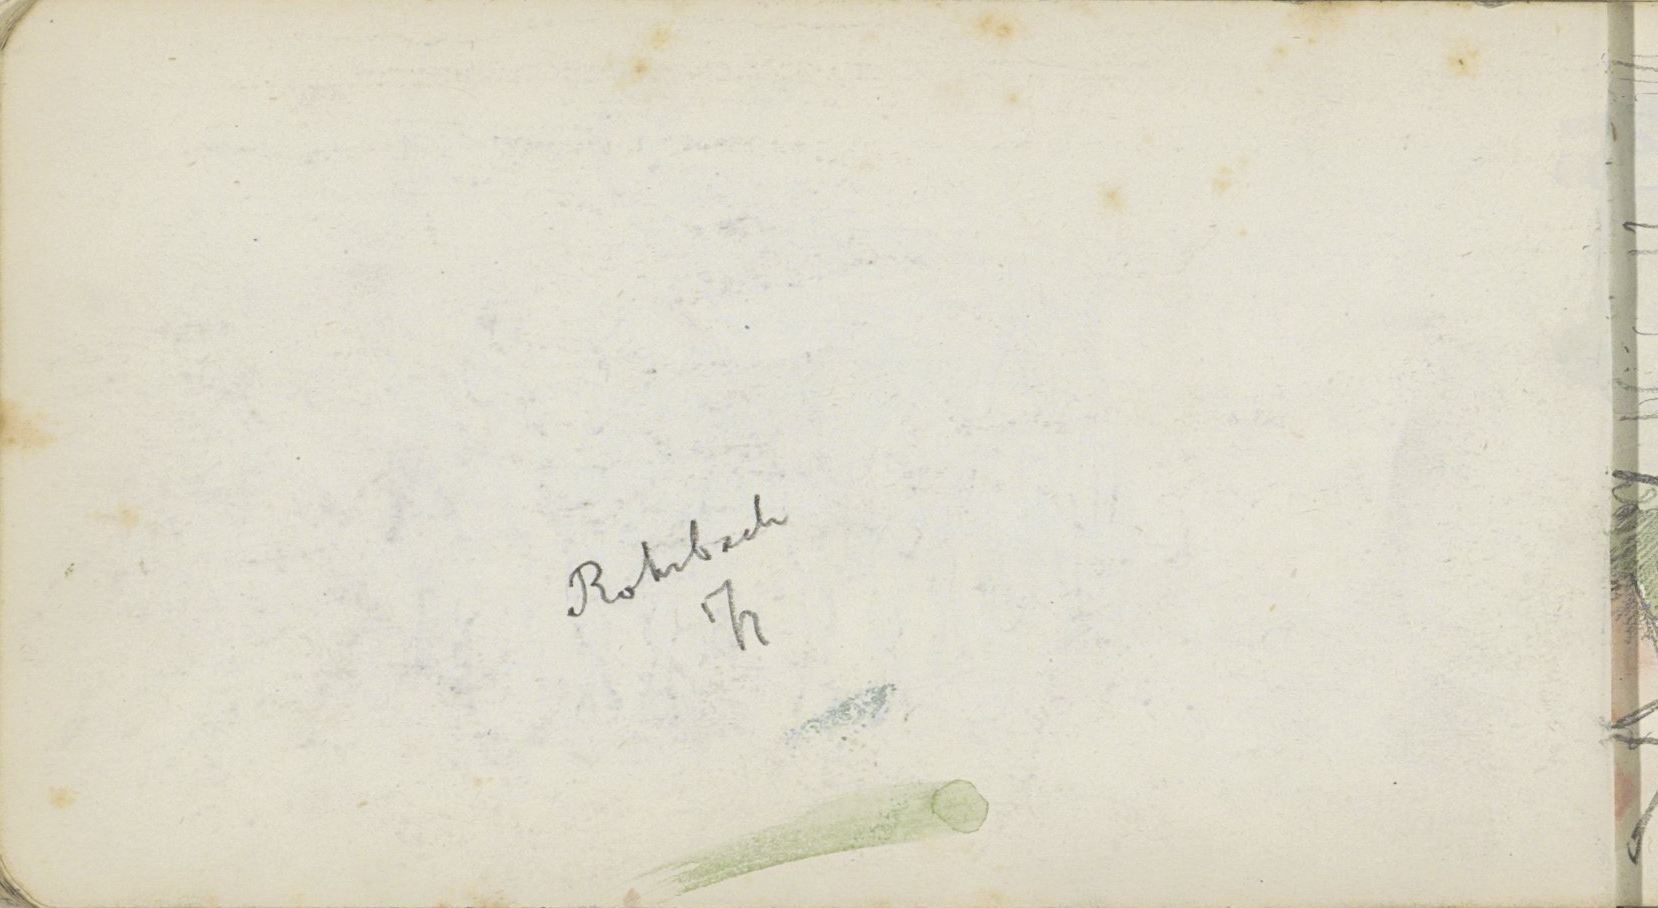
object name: sketchbook leaf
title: Notitie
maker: geo poggenbeek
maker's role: draughtsman, painter, print maker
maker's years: 1853-1903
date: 1807-1876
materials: paper, pencil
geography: rohrbach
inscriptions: date and inscription: ‘Rohrbach/ 1/7’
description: Blad 21 verso uit een schetsboek met 69 bladen.